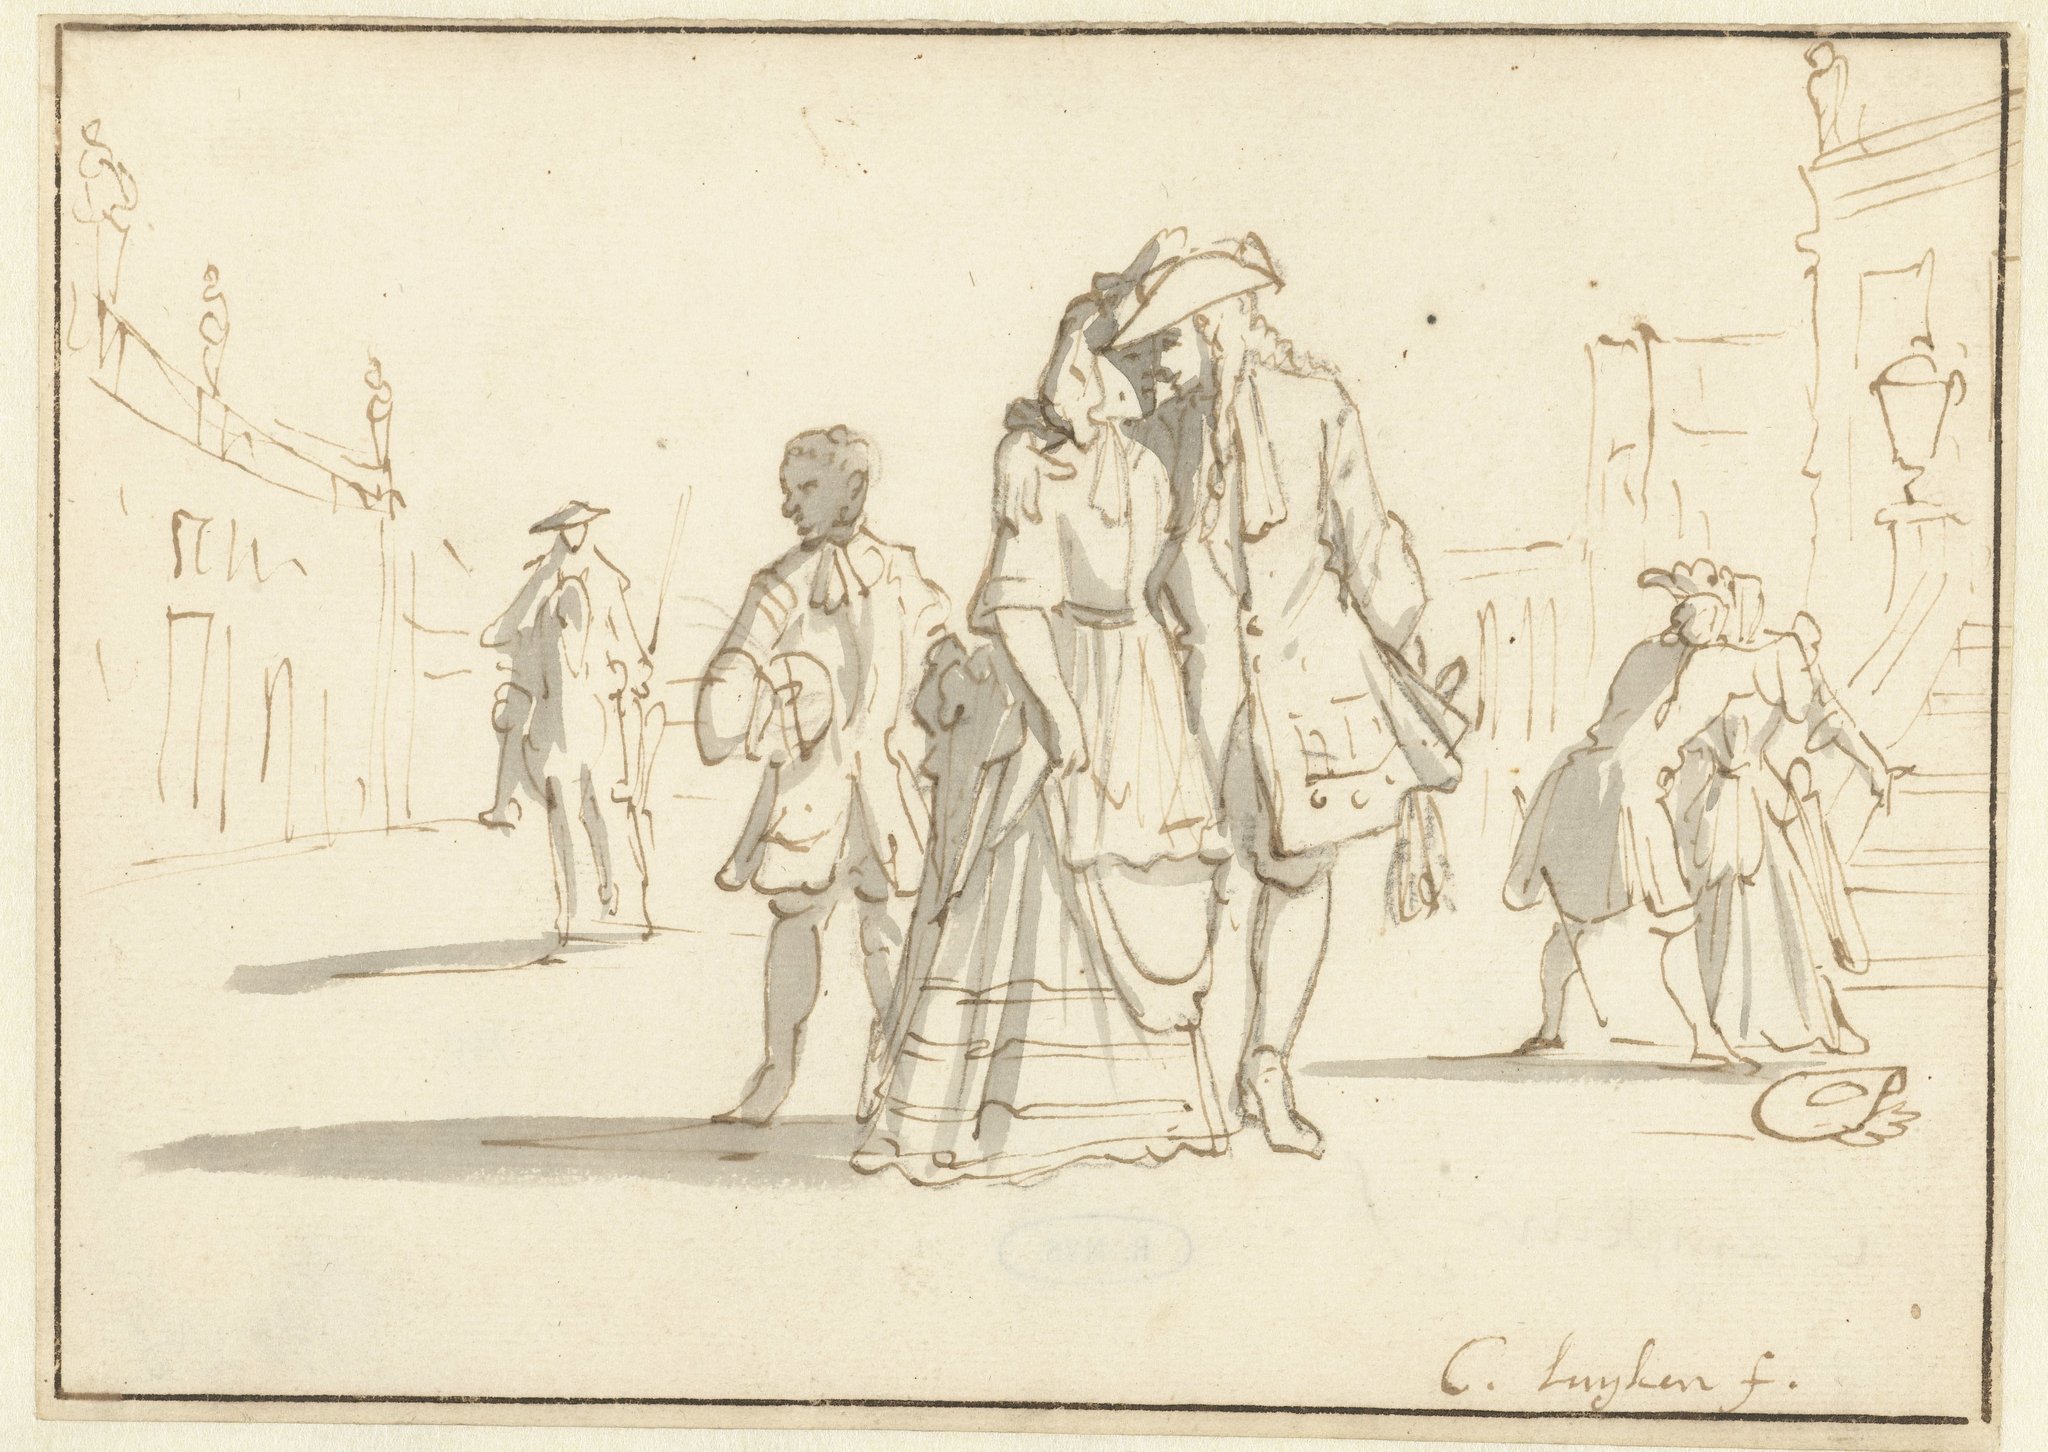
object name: drawing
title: Moor, ruiter en een liefdespaar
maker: caspar luyken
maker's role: draughtsman, print maker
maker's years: 1672-1708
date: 1682-1708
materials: chalk, ink, paper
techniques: brush, pen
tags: (lovers) embracing each other, 'symplegma'